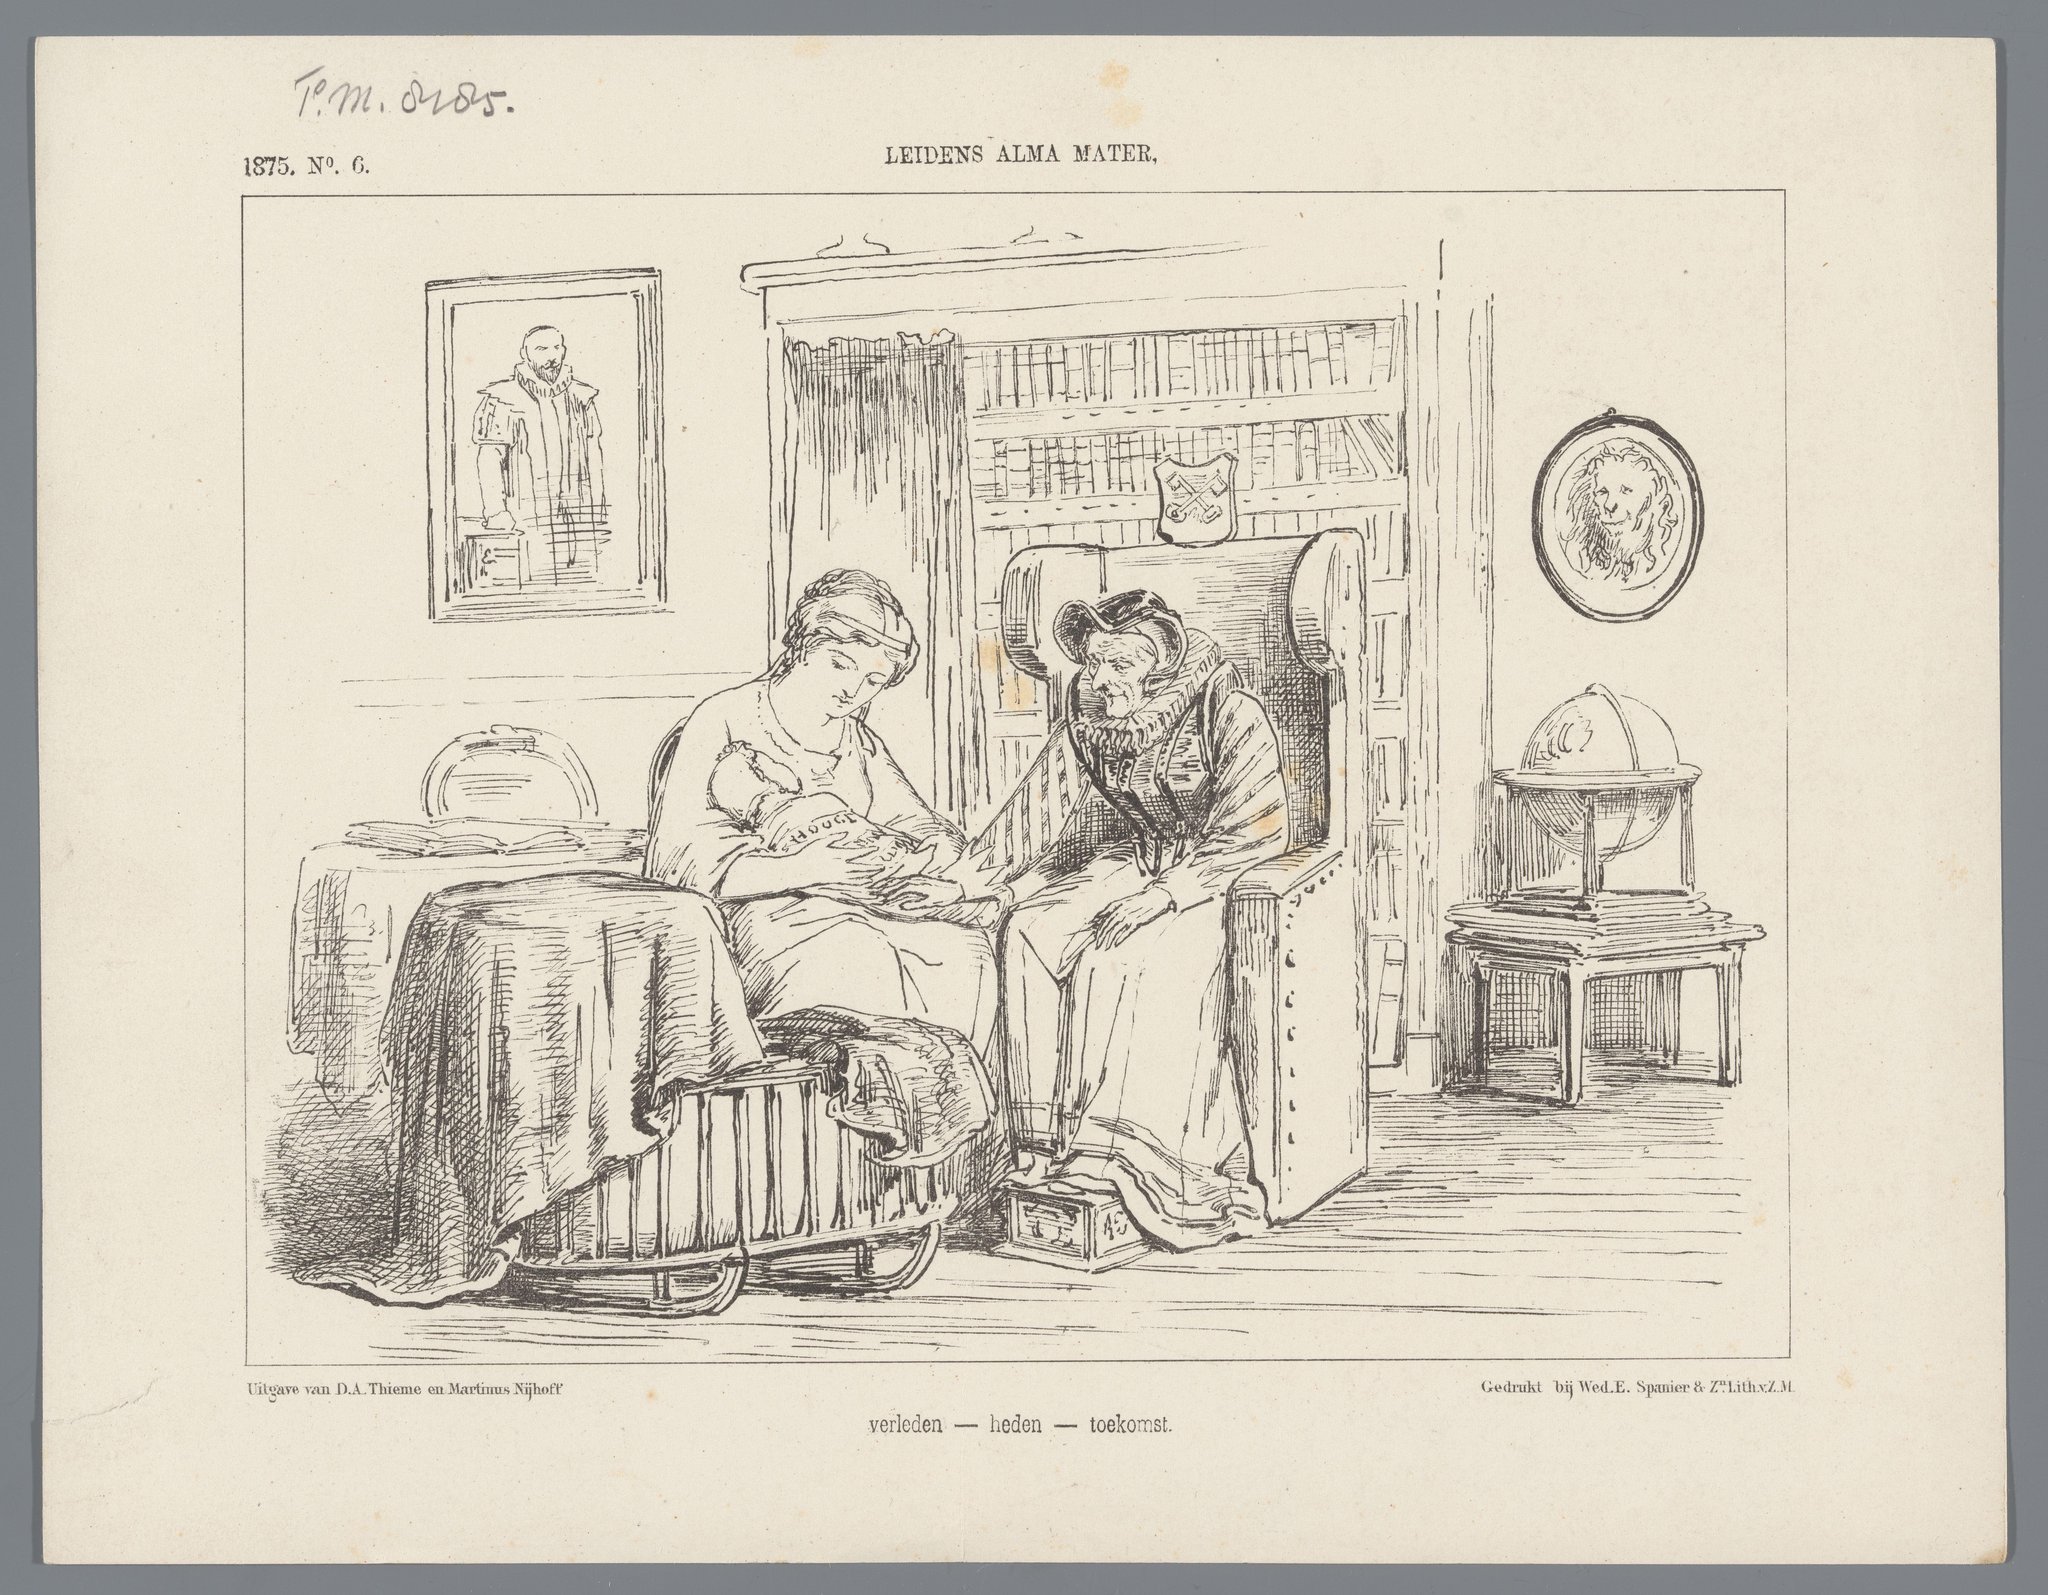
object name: cartoon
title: Leidens Alma Mater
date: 1875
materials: paper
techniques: lithograph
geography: netherlands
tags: commemoration of the founding of a university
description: Spotprent over Leidens Alma Mater, heden, verleden en toekomst. Plaat verschenen bij het weekblad De Nederlandsche Spectator, nr. 6, 1875.